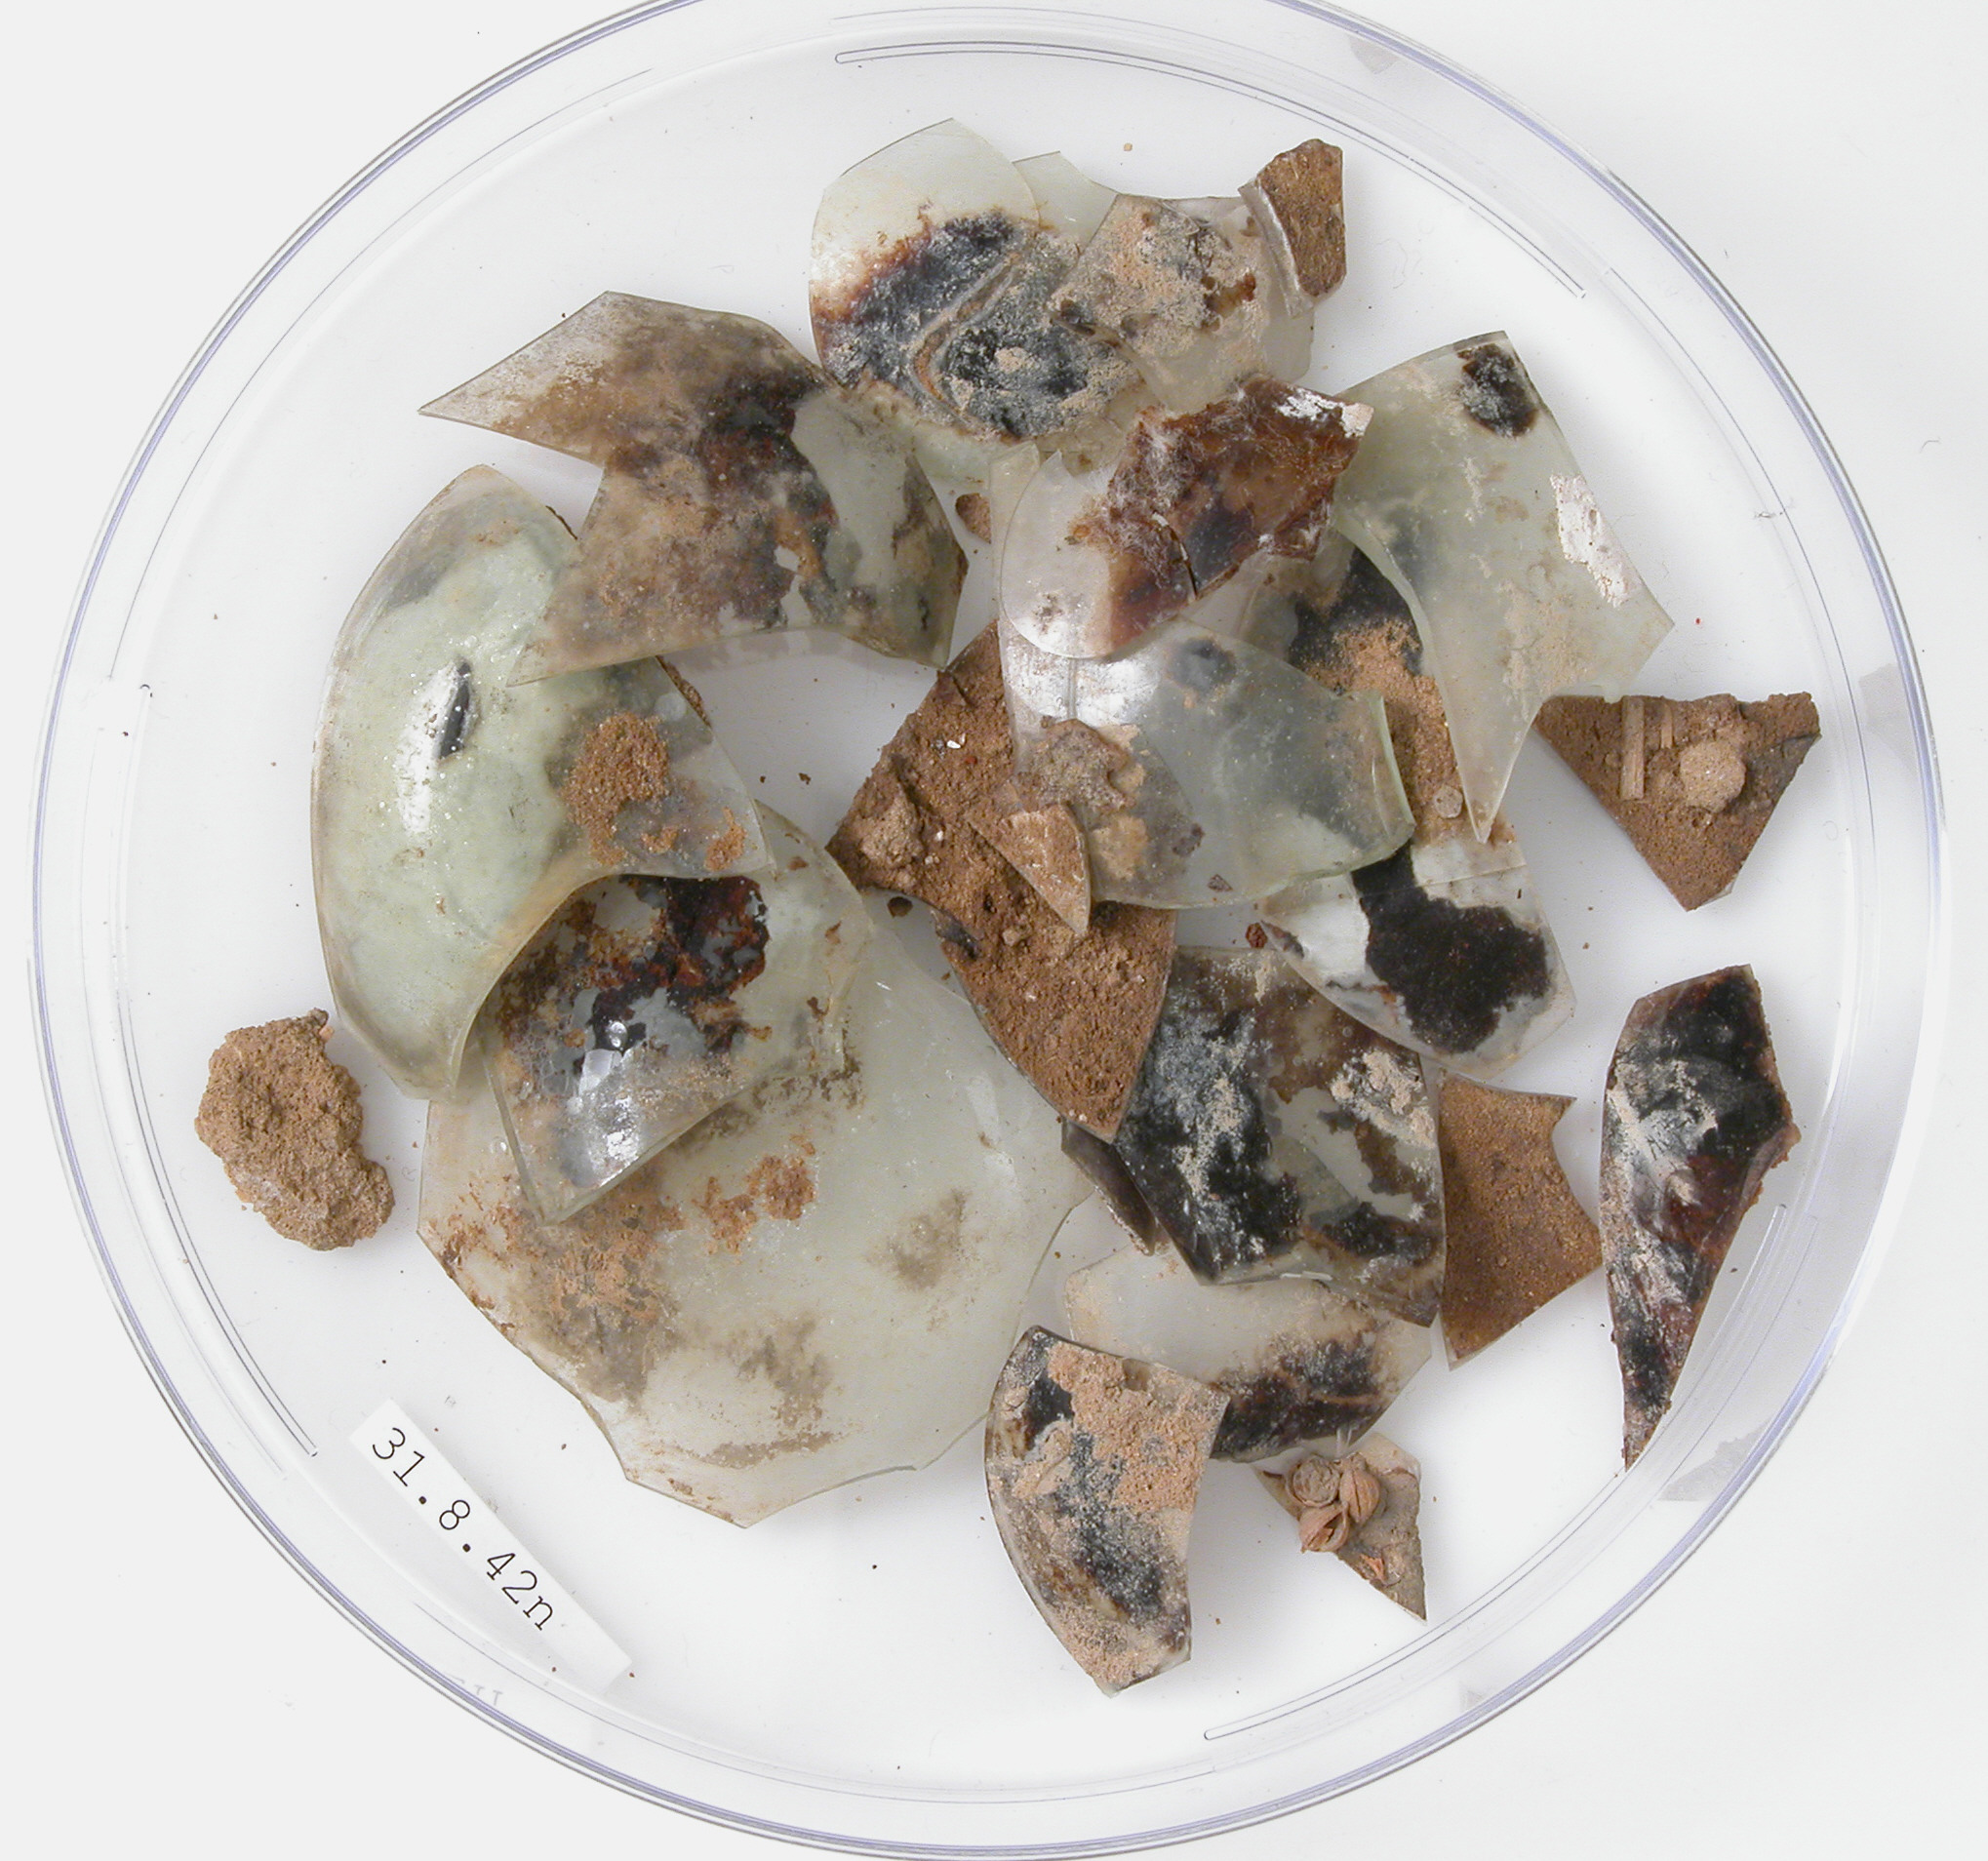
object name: fragment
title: Glass Fragments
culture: coptic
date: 301-400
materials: glass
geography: egypt